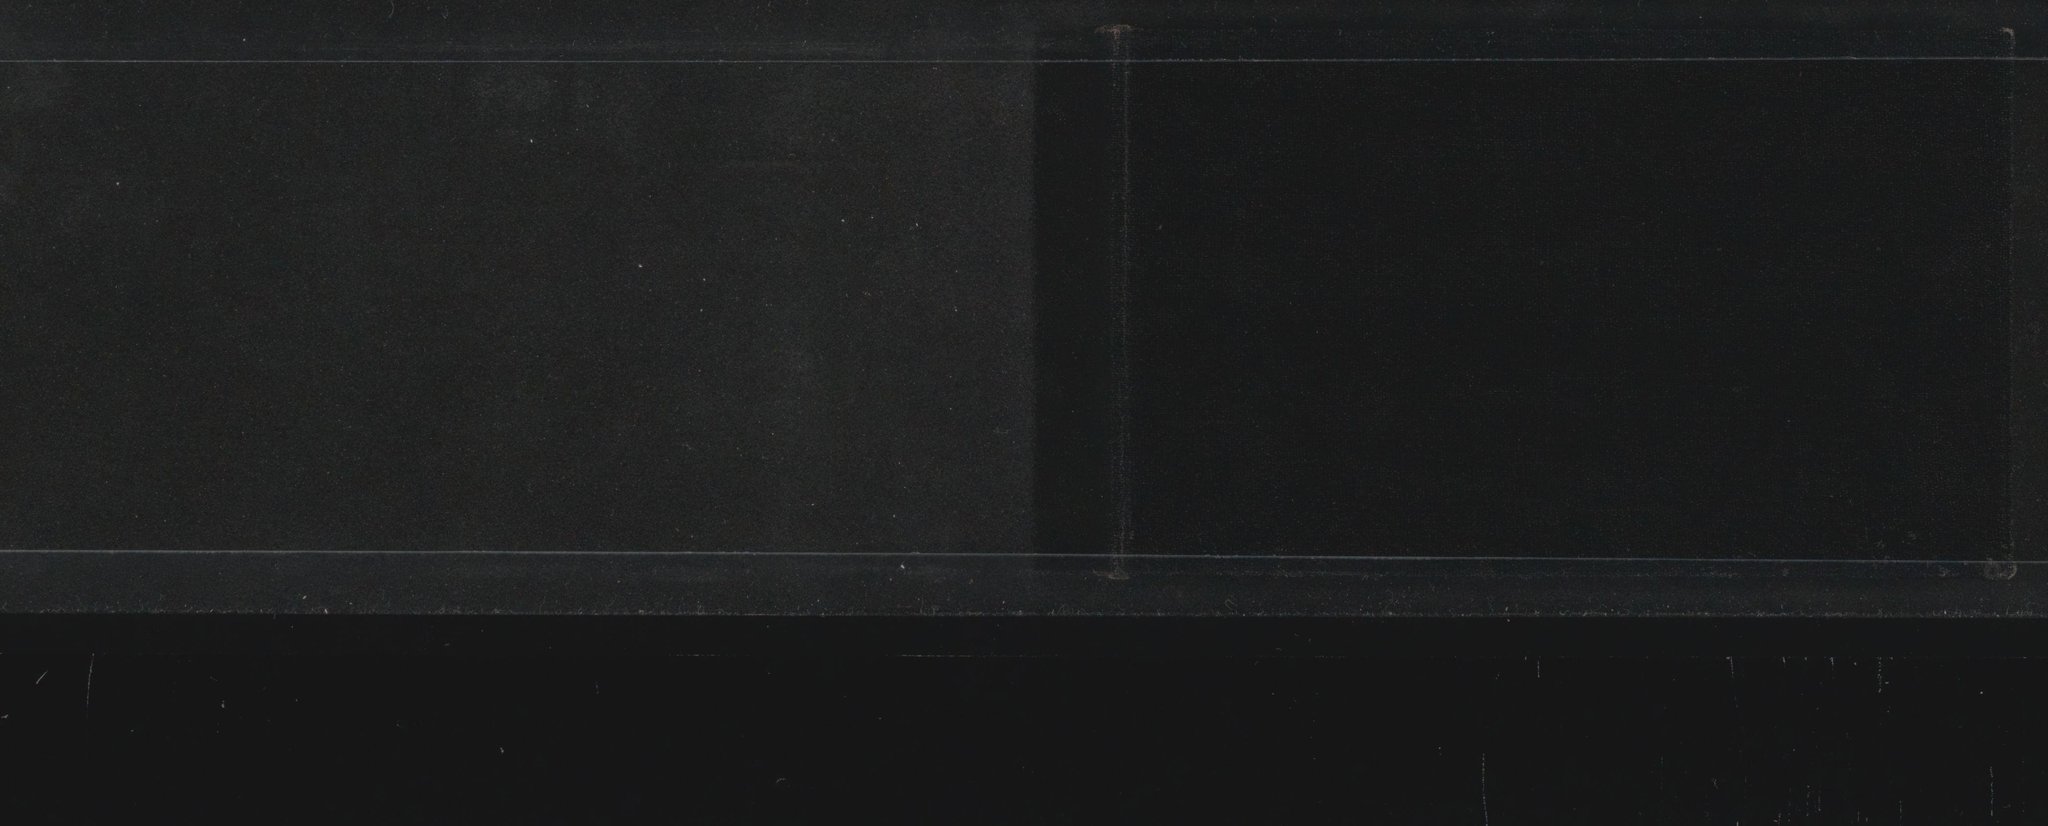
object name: sketchbook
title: Schetsboek met 44 bladen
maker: cornelis springer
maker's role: draughtsman, painter, print maker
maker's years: 1817-1891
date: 1860-1866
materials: cardboard, linen, paper, pencil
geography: netherlands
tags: city-view, and landscape with man-made constructions, adult woman, adult man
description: Schetsboek bestaande uit 44 bladen met figuren, een staande klok en stadsgezichten met topografische annotaties.